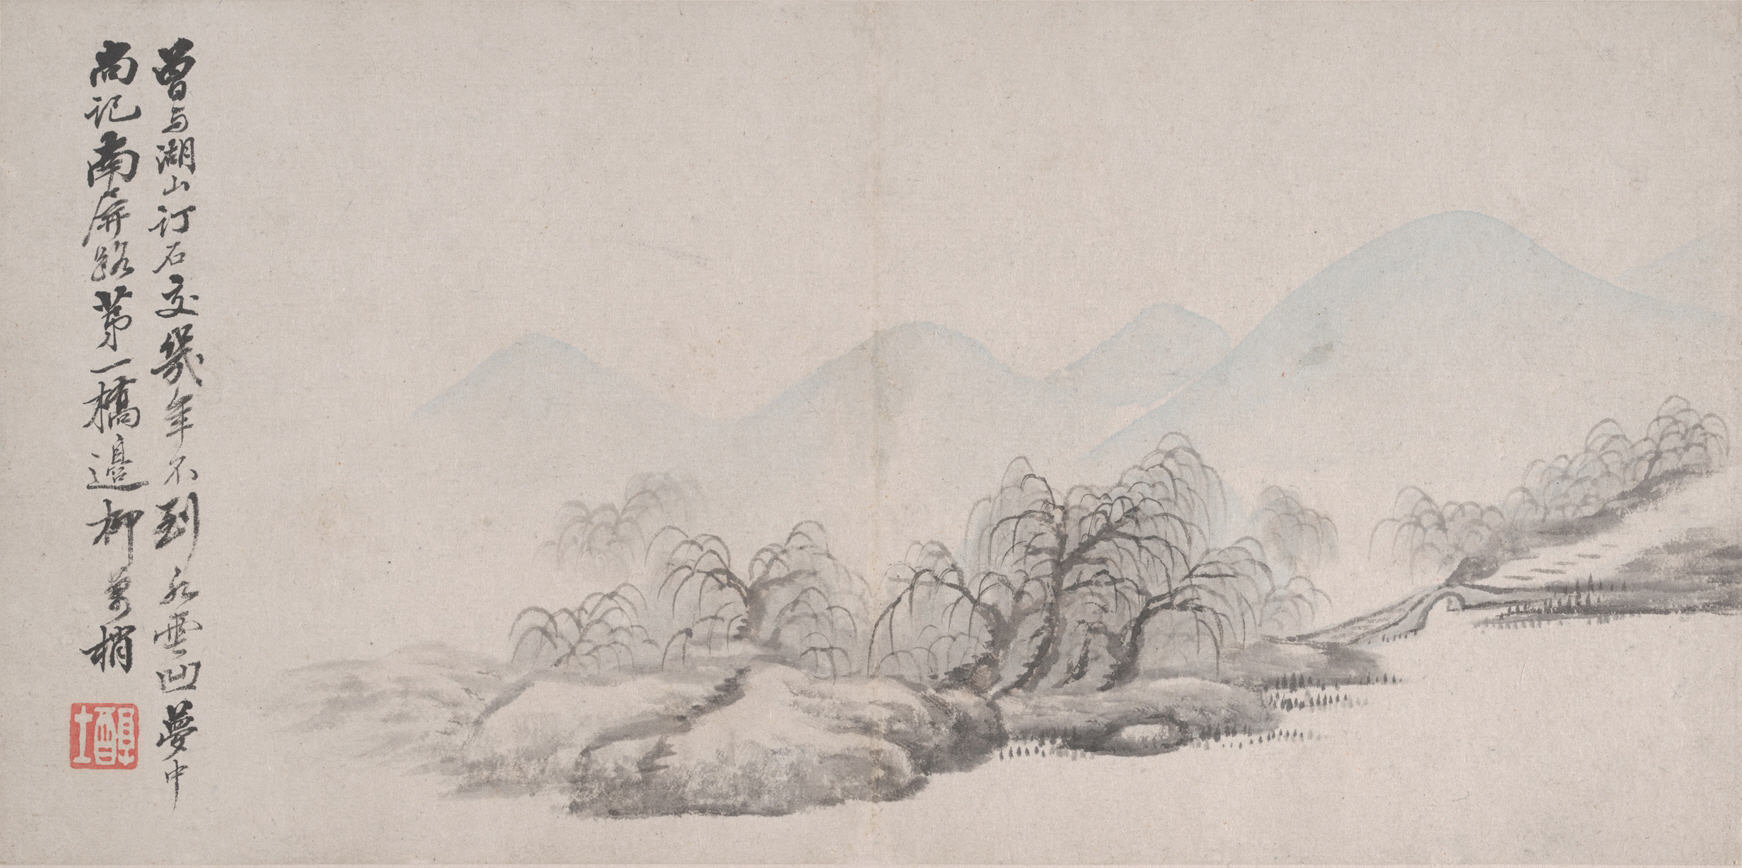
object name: album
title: Landscapes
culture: chinese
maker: dai xi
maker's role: artist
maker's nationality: chinese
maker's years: 1801-1860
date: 1848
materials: ink, paper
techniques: painting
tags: landscapes